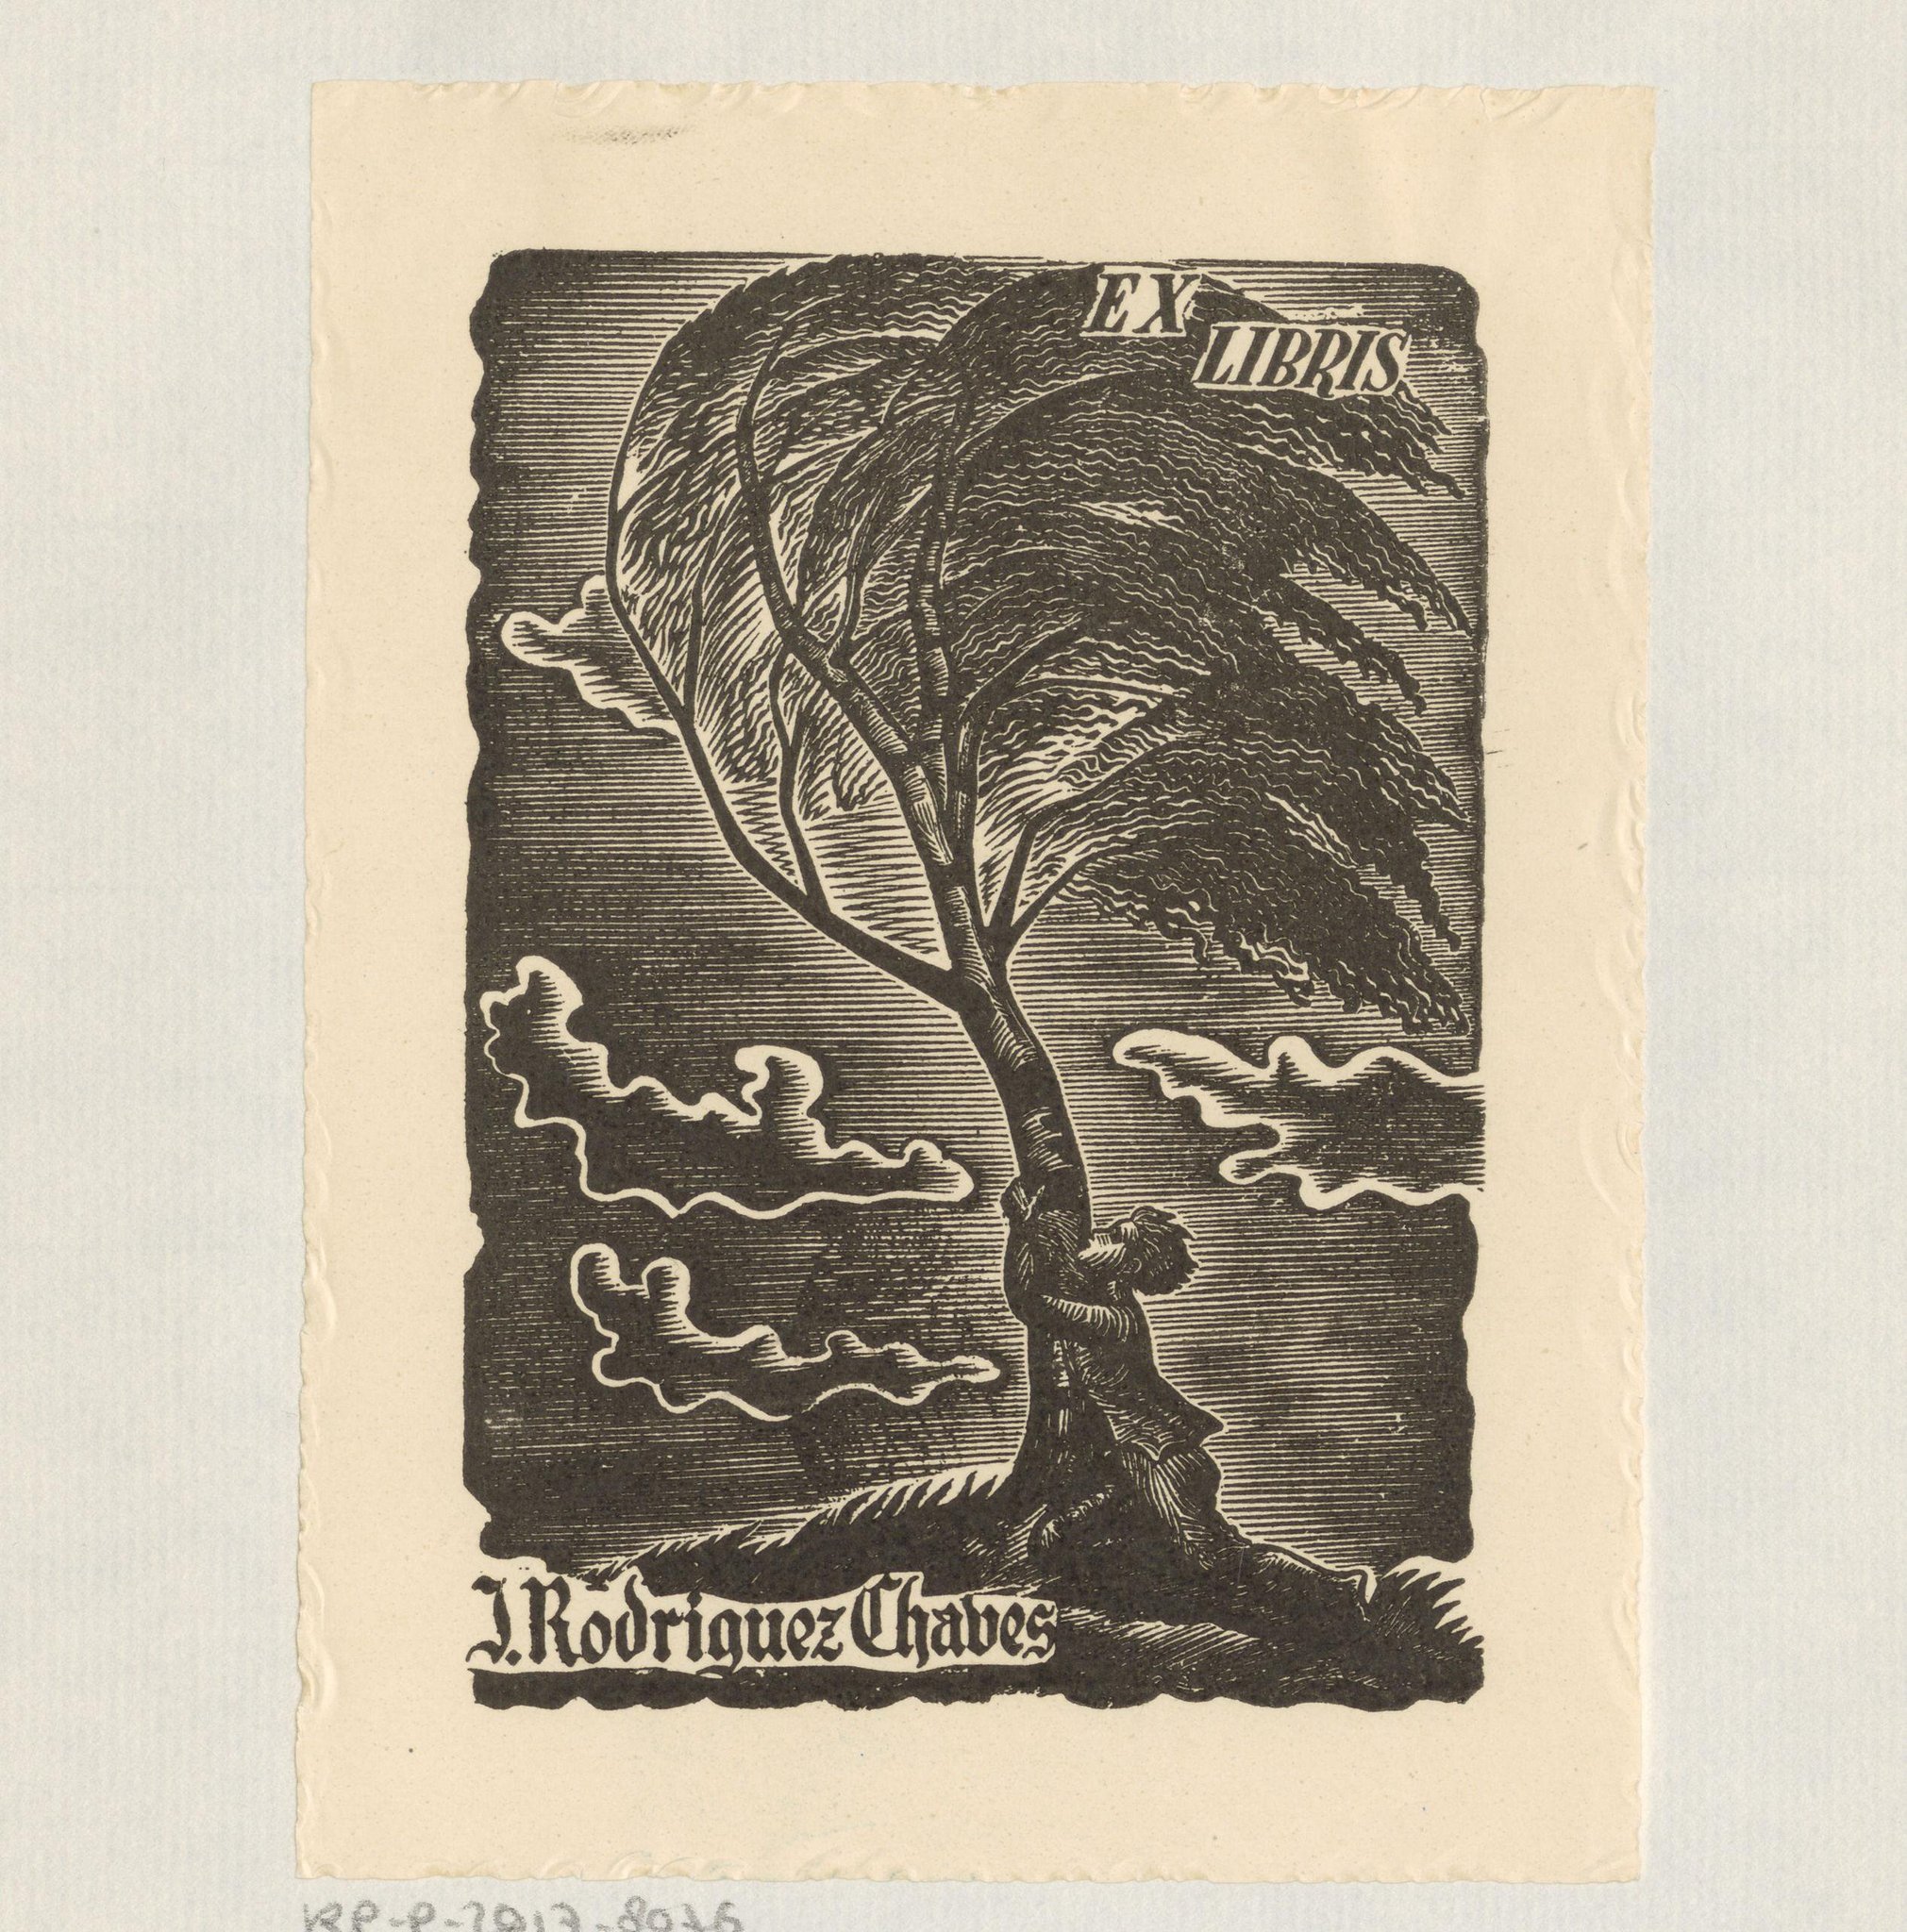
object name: bookplate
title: Ex libris J. Rodriguez Chaves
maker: valentin le campion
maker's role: print maker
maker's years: 1861-1952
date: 1936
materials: paper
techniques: engraving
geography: france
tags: josé rodriguez chaves, trees, kneeling figure, geological phenomena